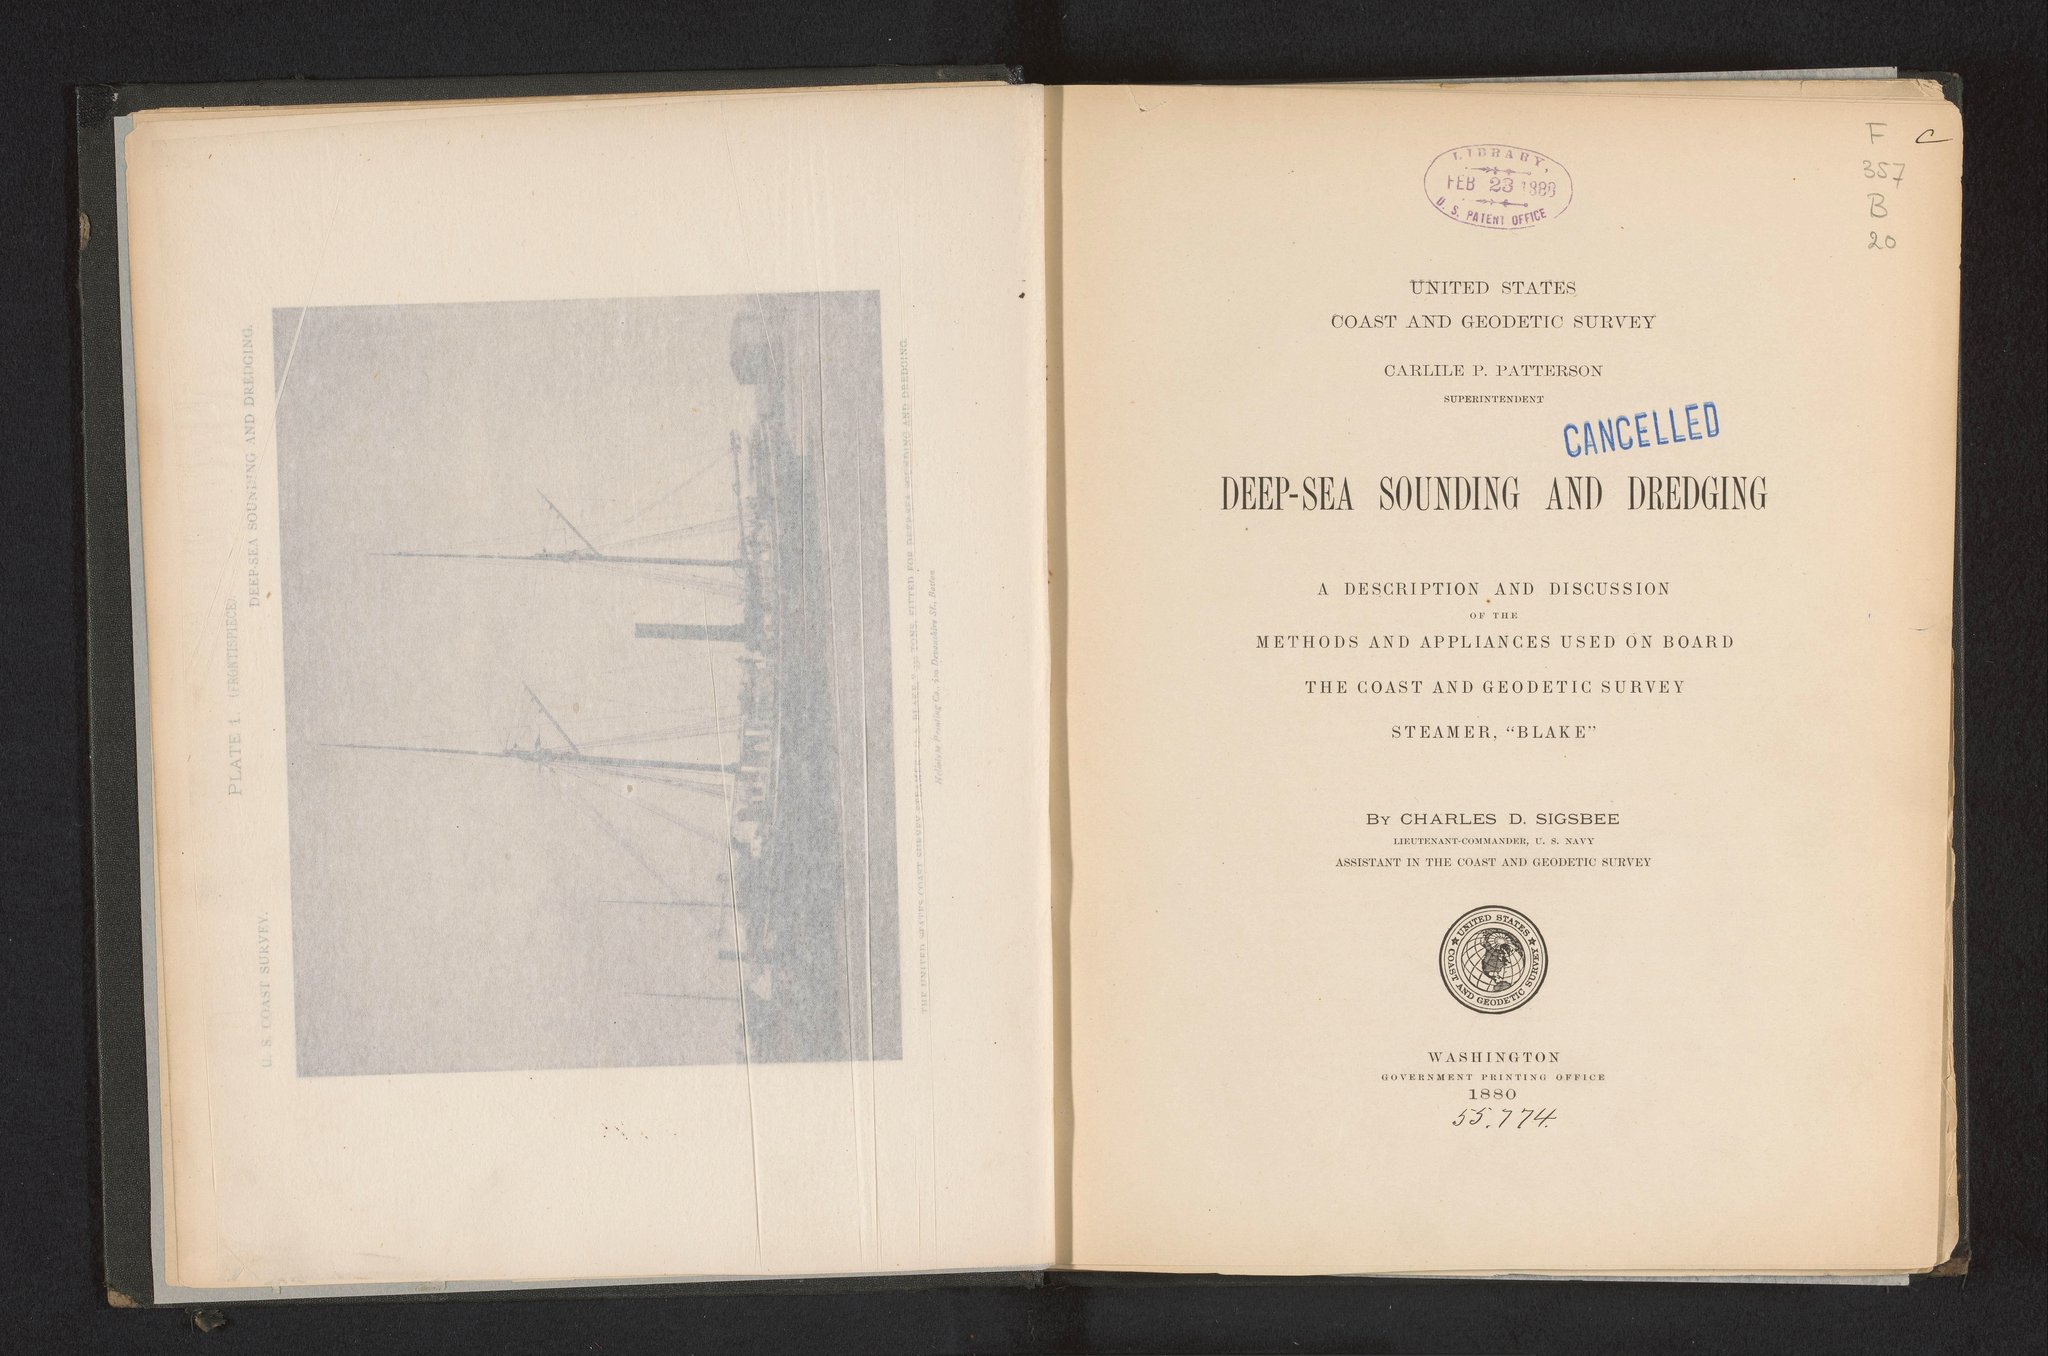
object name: book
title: Deep-sea sounding and dredging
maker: charles d. sigsbee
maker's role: militair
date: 1880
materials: cardboard, linen, paper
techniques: photograph, lithograph, printing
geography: washington d.c.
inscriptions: inscription: ‘surplus -1 Library of Congress duplicate’, inscription: ‘Library Feb. 23 1888 U. S. Patent Office’, name: ‘Scientific Library United States Patent Office’